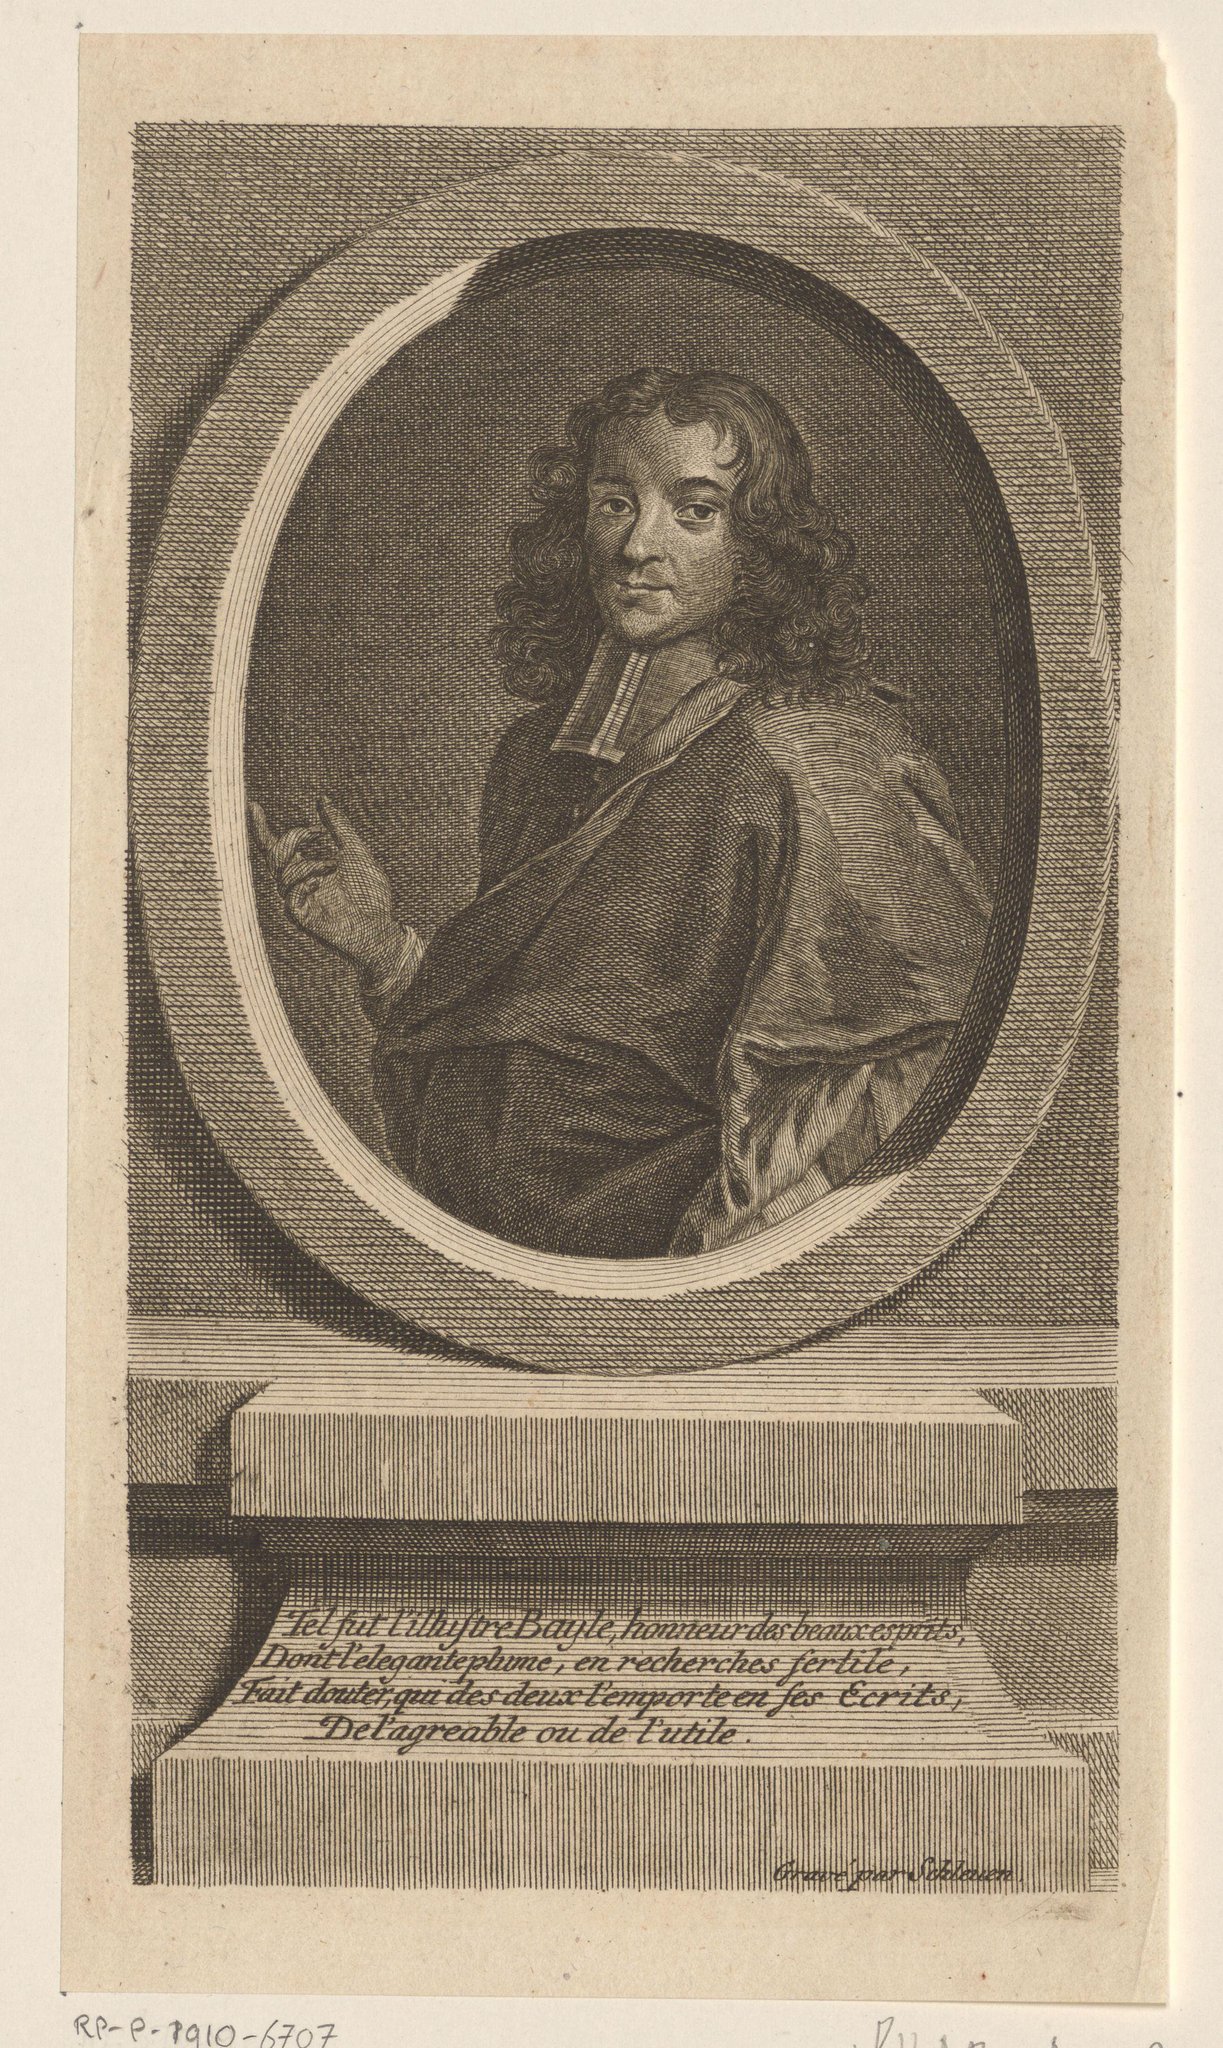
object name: print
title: Portret van Pierre Bayle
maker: johann david schleuen (i)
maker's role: print maker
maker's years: 1711-1774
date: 1740-1771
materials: paper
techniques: engraving, etching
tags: rotterdam, historical persons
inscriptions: collector's mark: Lugt 2228